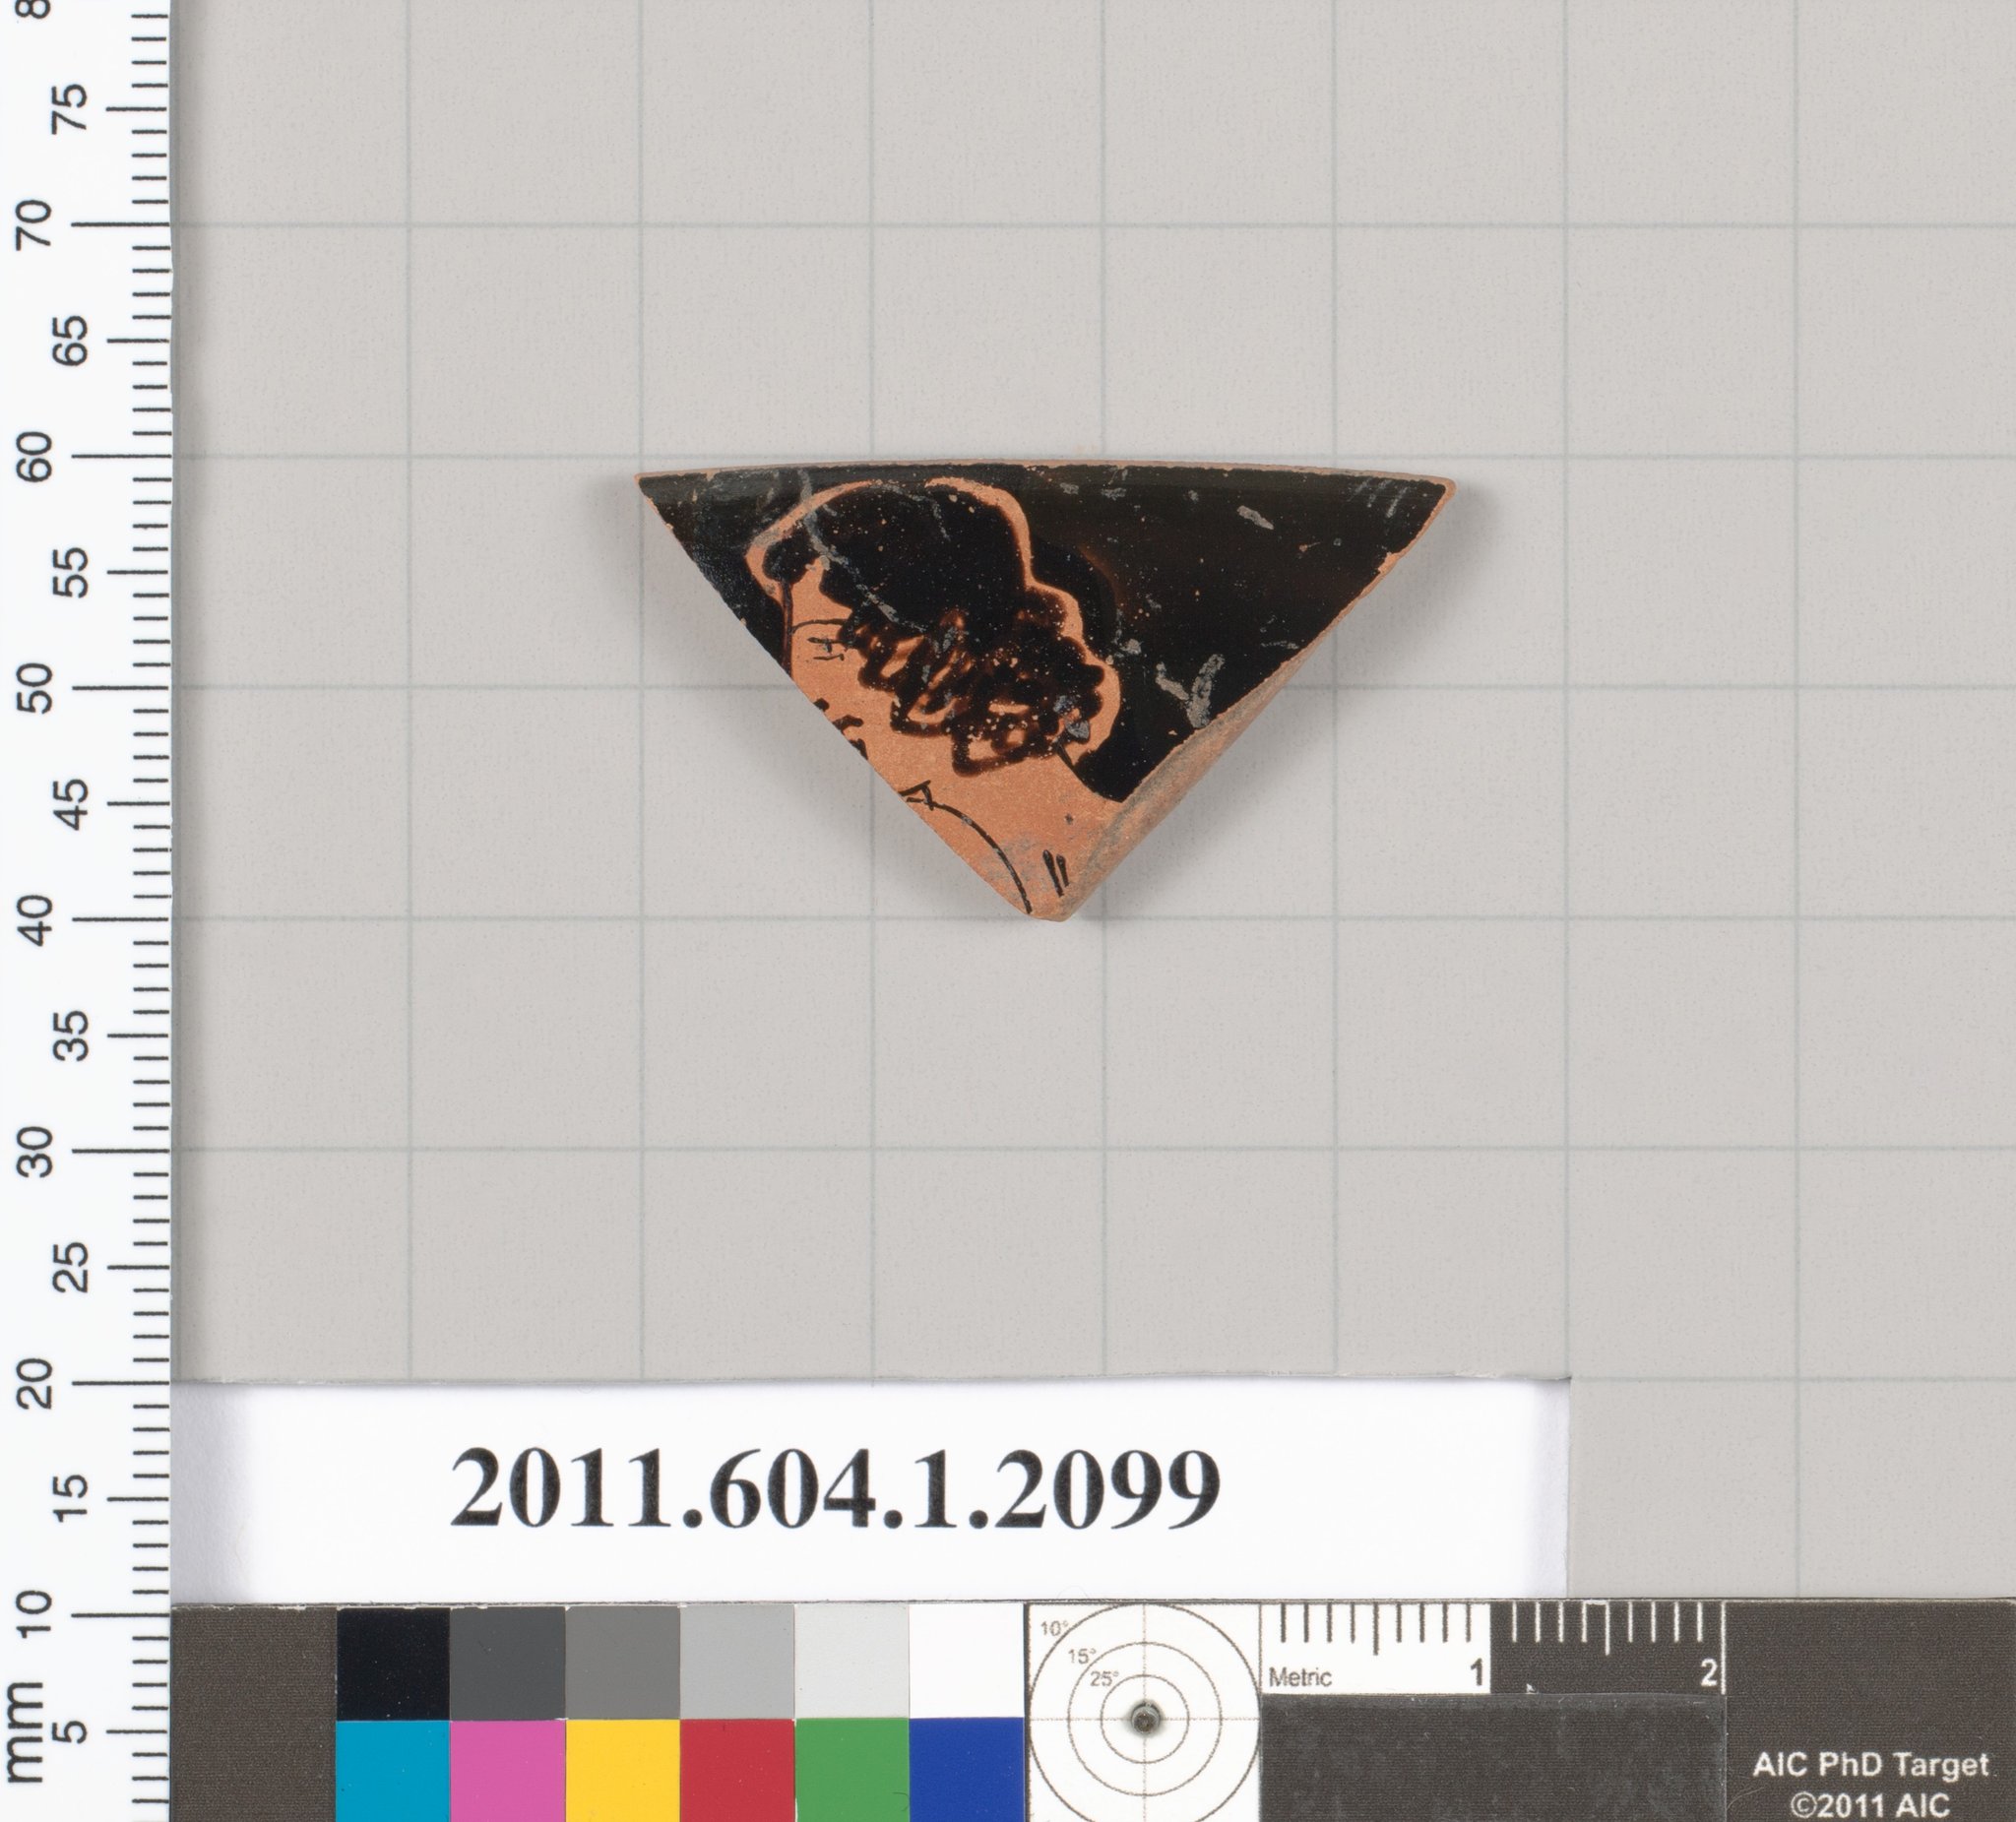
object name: kylix fragment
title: Terracotta rim fragment of a kylix (drinking cup)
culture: greek, attic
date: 467-435 BCE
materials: terracotta